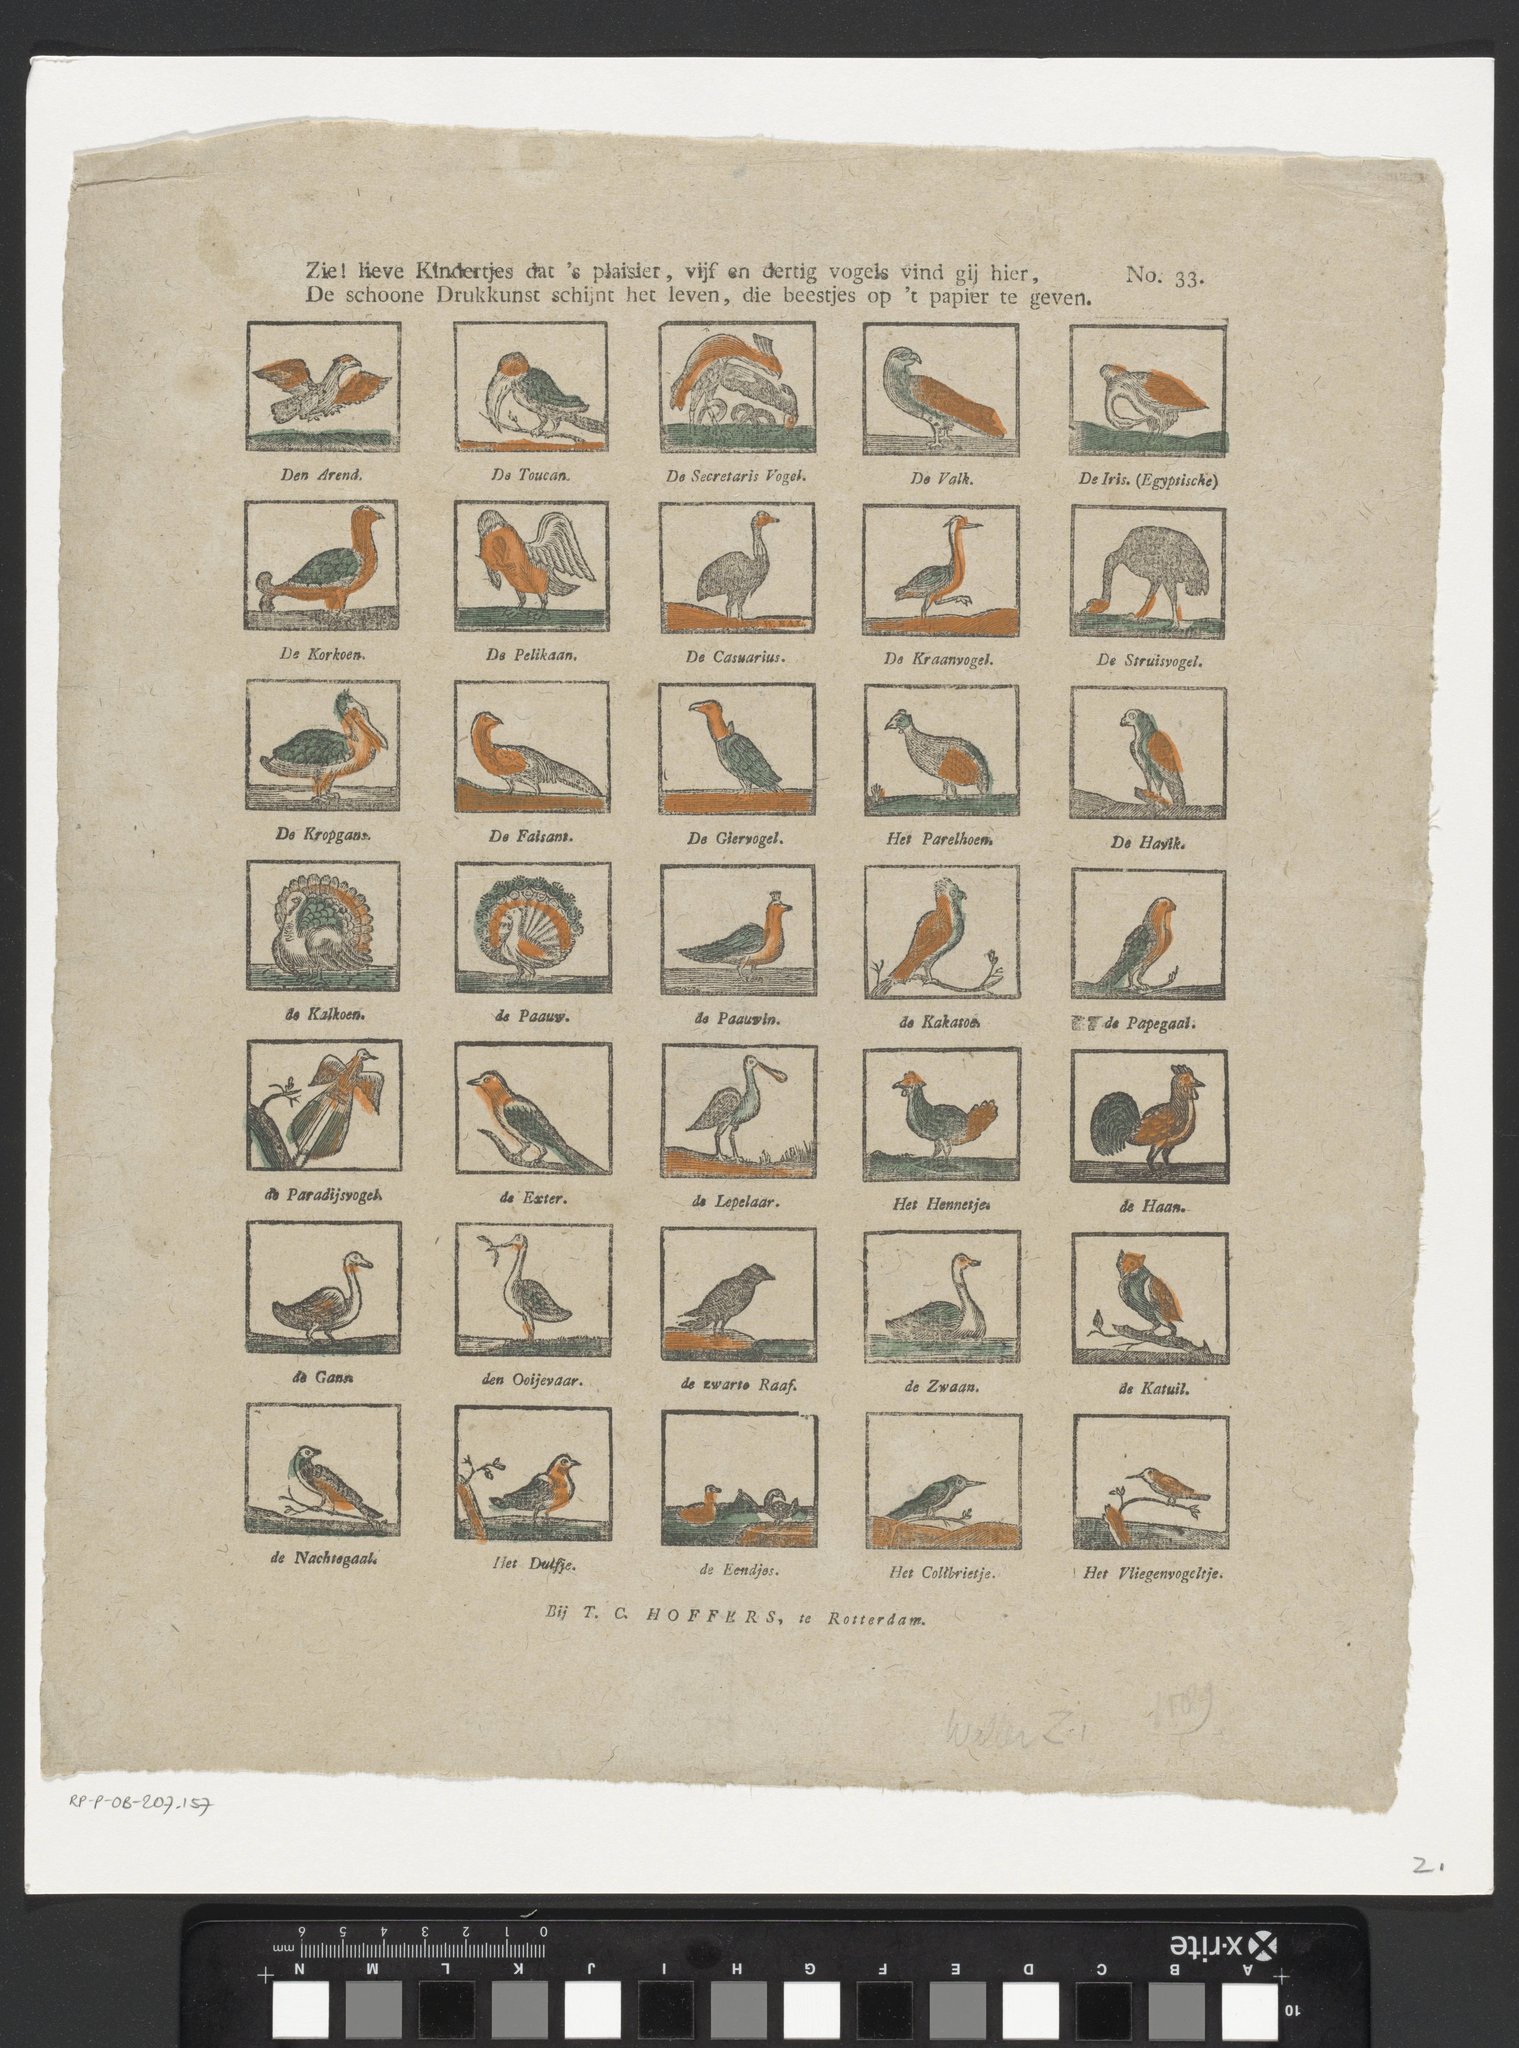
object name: print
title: Zie! lieve kindertjes dat 's plaisier, vijf en dertig vogels vind gij hier, / De schoone drukkunst schijnt het leven, die beestjes op 't papier te geven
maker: Anonymous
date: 1840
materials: paper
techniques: colour, letterpress printing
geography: the hague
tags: birds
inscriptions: date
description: Blad met 35 voorstellingen van vogels. Onder elke afbeelding een onderschrift. Genummerd rechtsboven: No. 33.